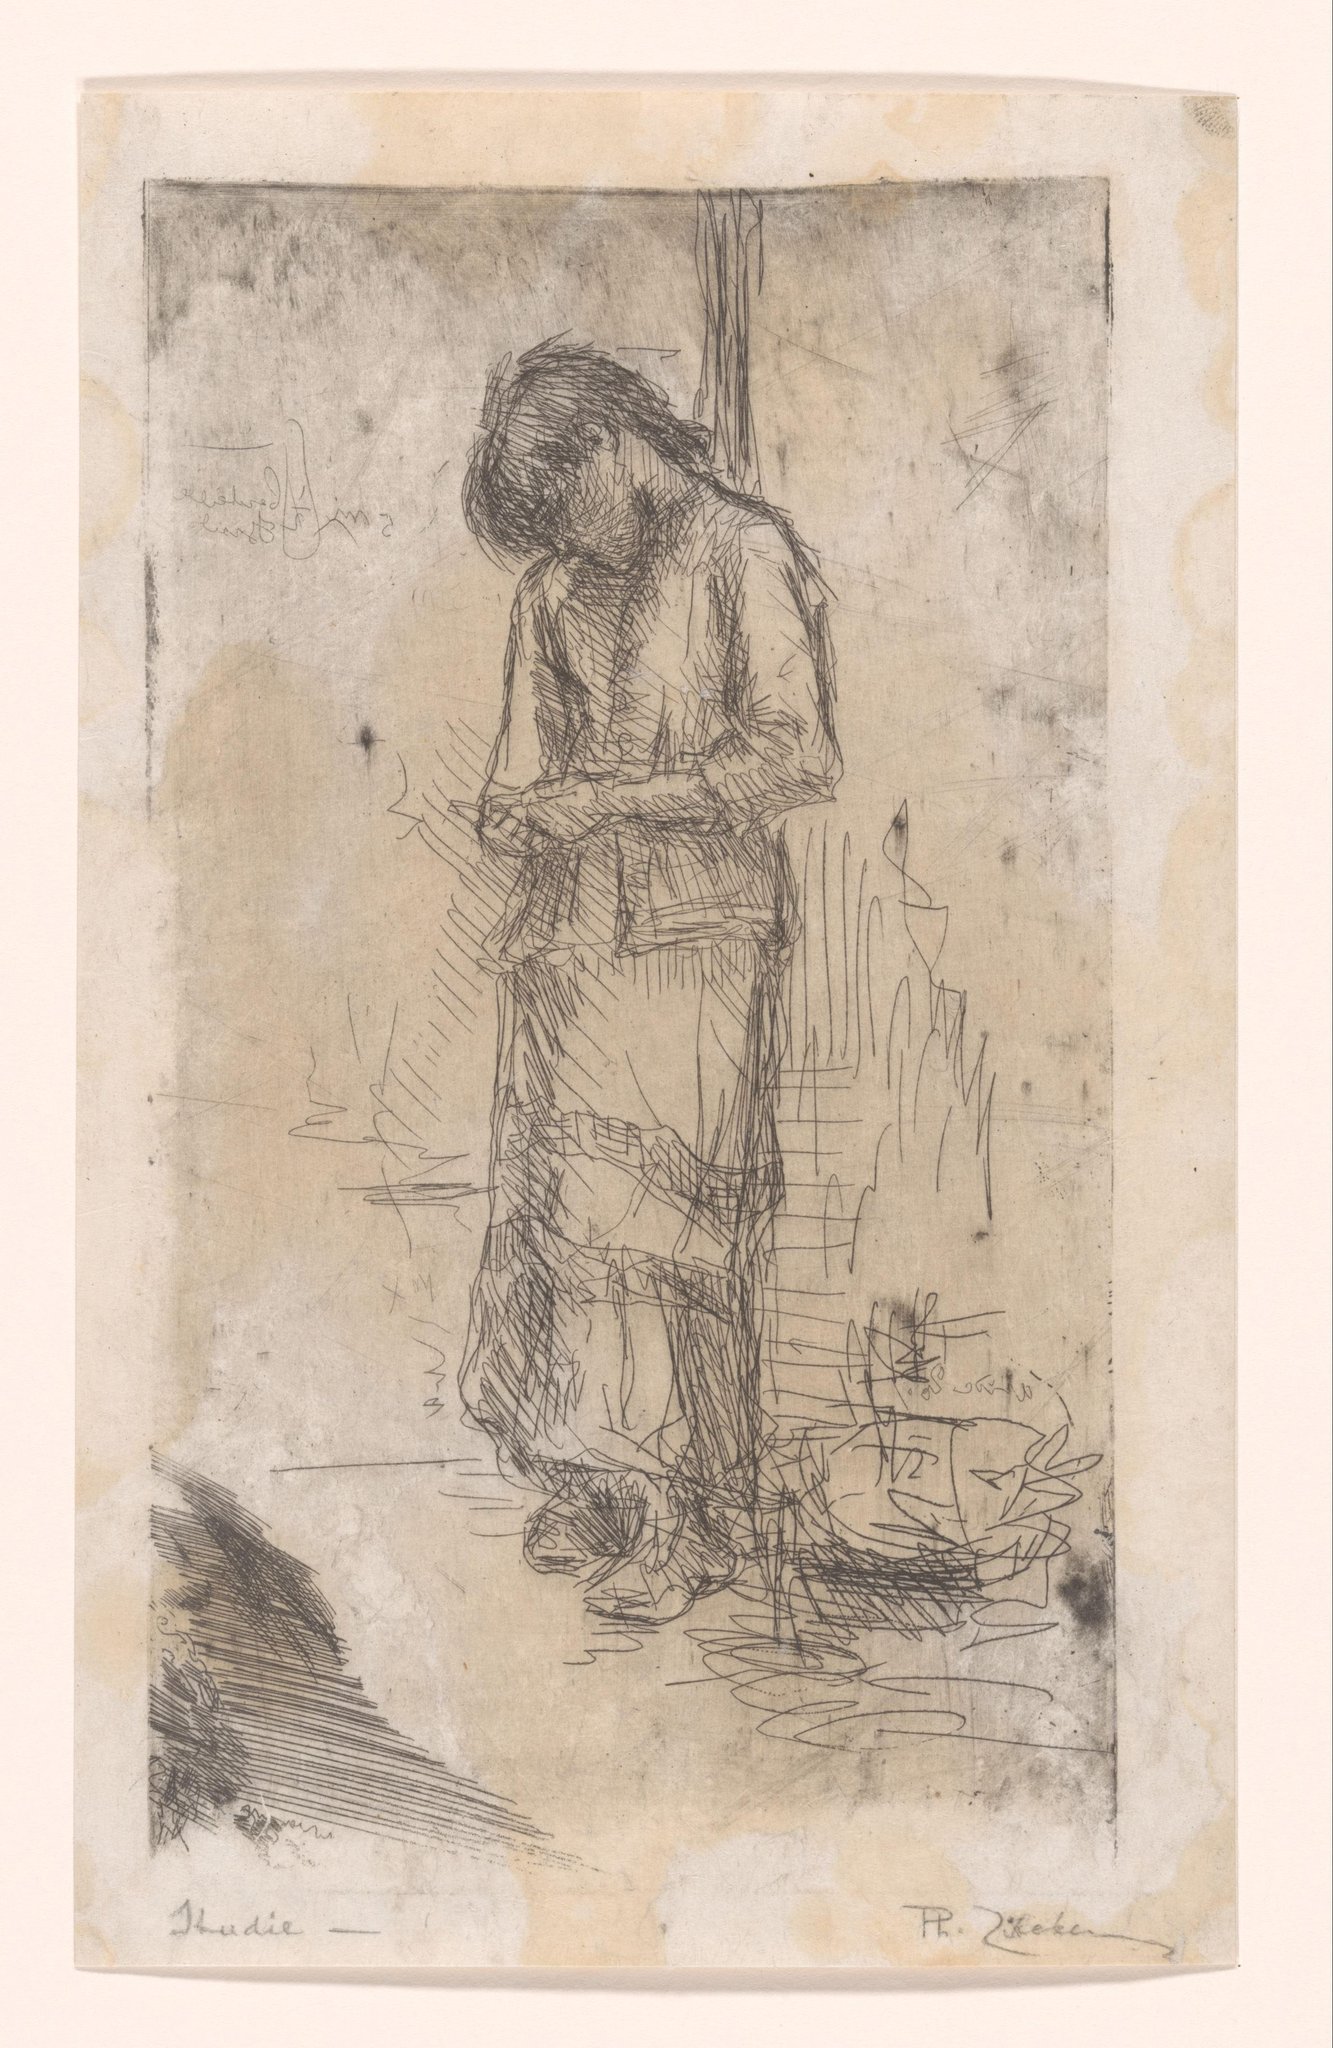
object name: print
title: Bedelend meisje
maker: philip zilcken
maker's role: draughtsman, painter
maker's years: 1857-1930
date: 1867-1890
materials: paper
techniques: drypoint, etching, intaglio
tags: girl (child between toddler and youth), beggar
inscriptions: collector's mark: Lugt 2228, annotation: ‘Studie’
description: Dit is het enige bekende exemplaar van deze prent.